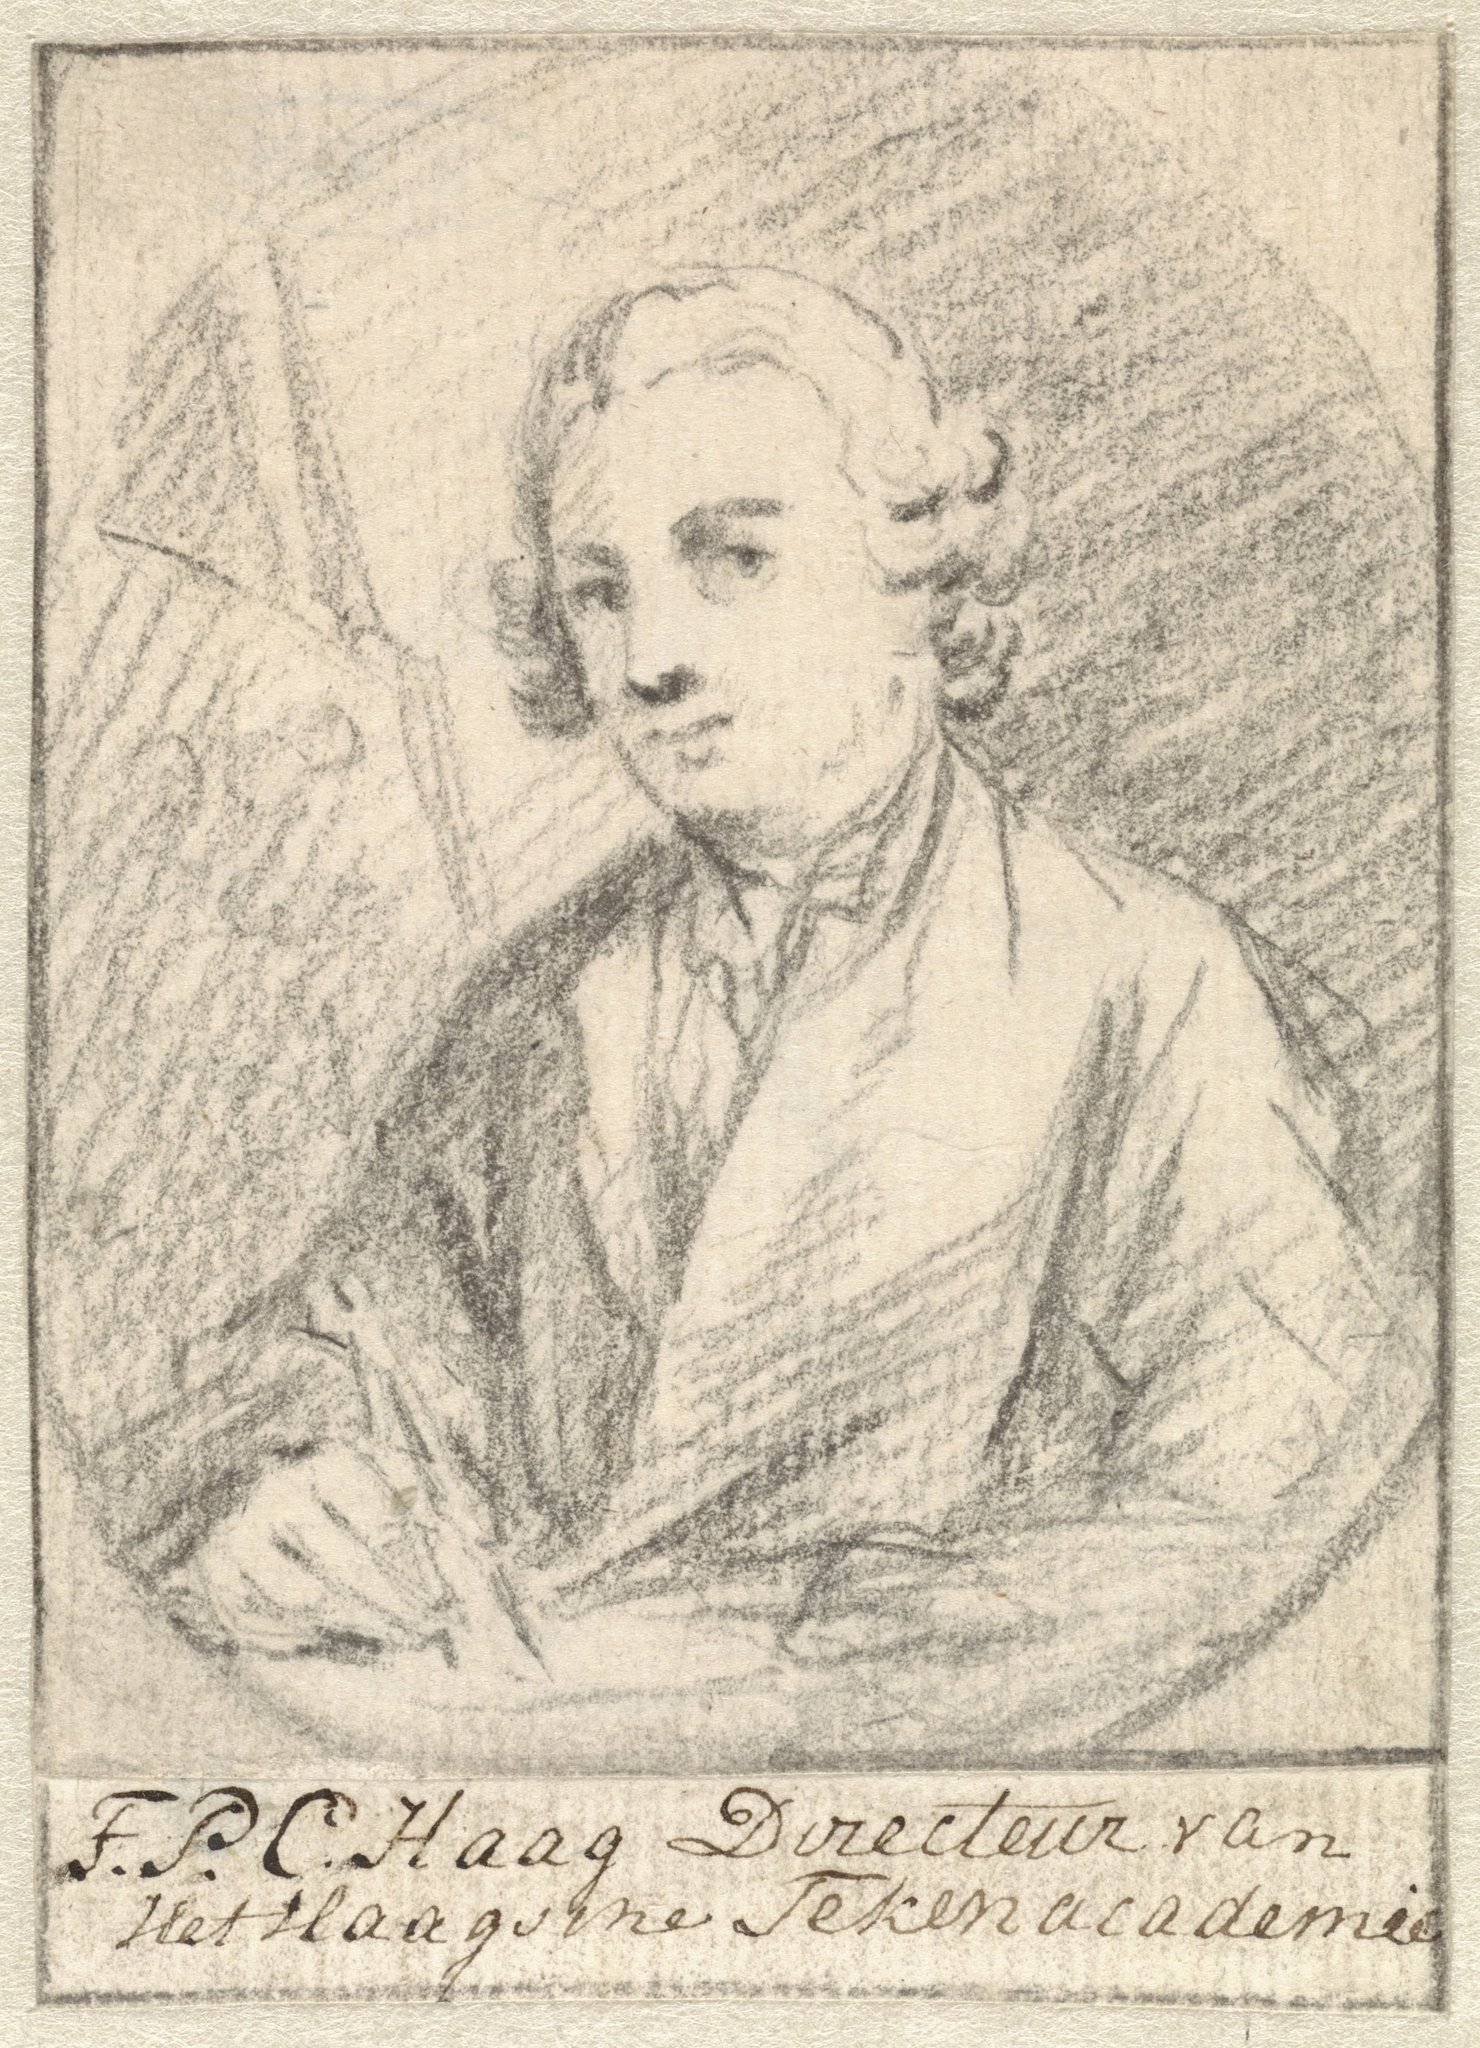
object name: drawing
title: Zelfportret van Tethart Philip Christian Haag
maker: tethart philip christian haag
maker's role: draughtsman, print maker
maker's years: 1737-1812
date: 1757-1812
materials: chalk, paper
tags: the hague, print maker, draughtsman, tethart philip christian haag, historical persons, portrait, self-portrait of painter, portrait, self-portrait of artist, portrait, self-portrait of draughtsman